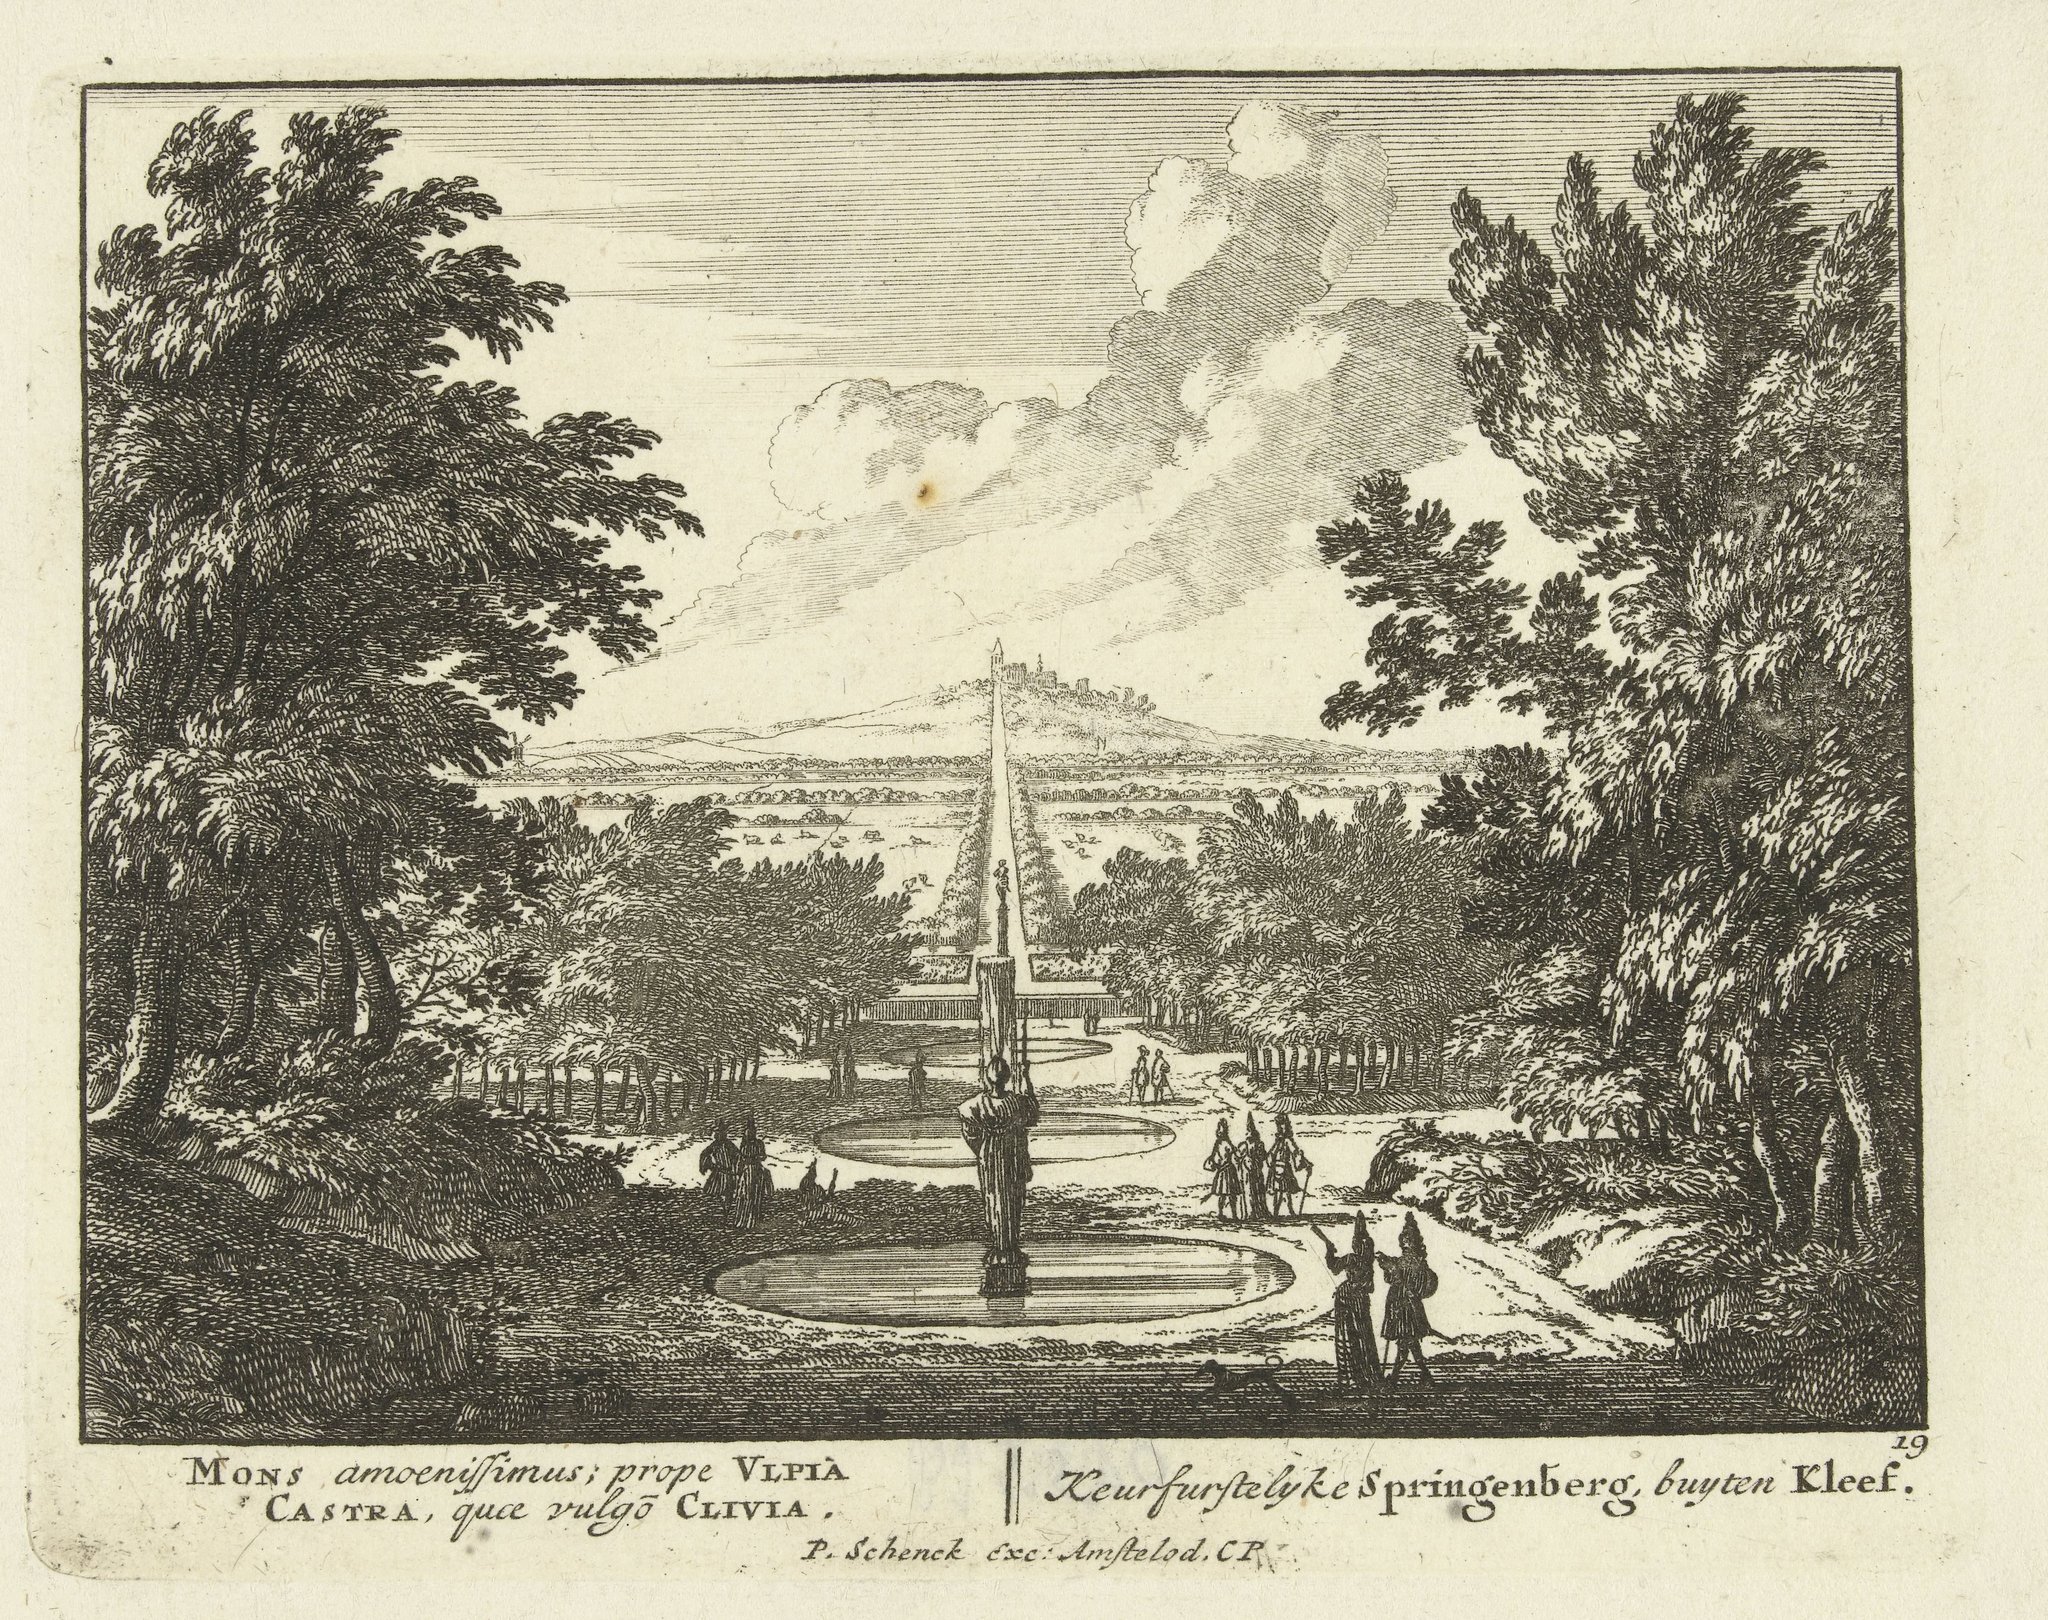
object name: print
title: Gezicht op de Springenberg bij Kleef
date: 1694-1697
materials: paper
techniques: etching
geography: amsterdam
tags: cleves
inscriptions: collector's mark: Lugt 2228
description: Prent uit een serie van 71 prenten met Rijnlandschappen, gezichten op vorstelijke paleizen en stadsgezichten uit Den Haag en Amsterdam.